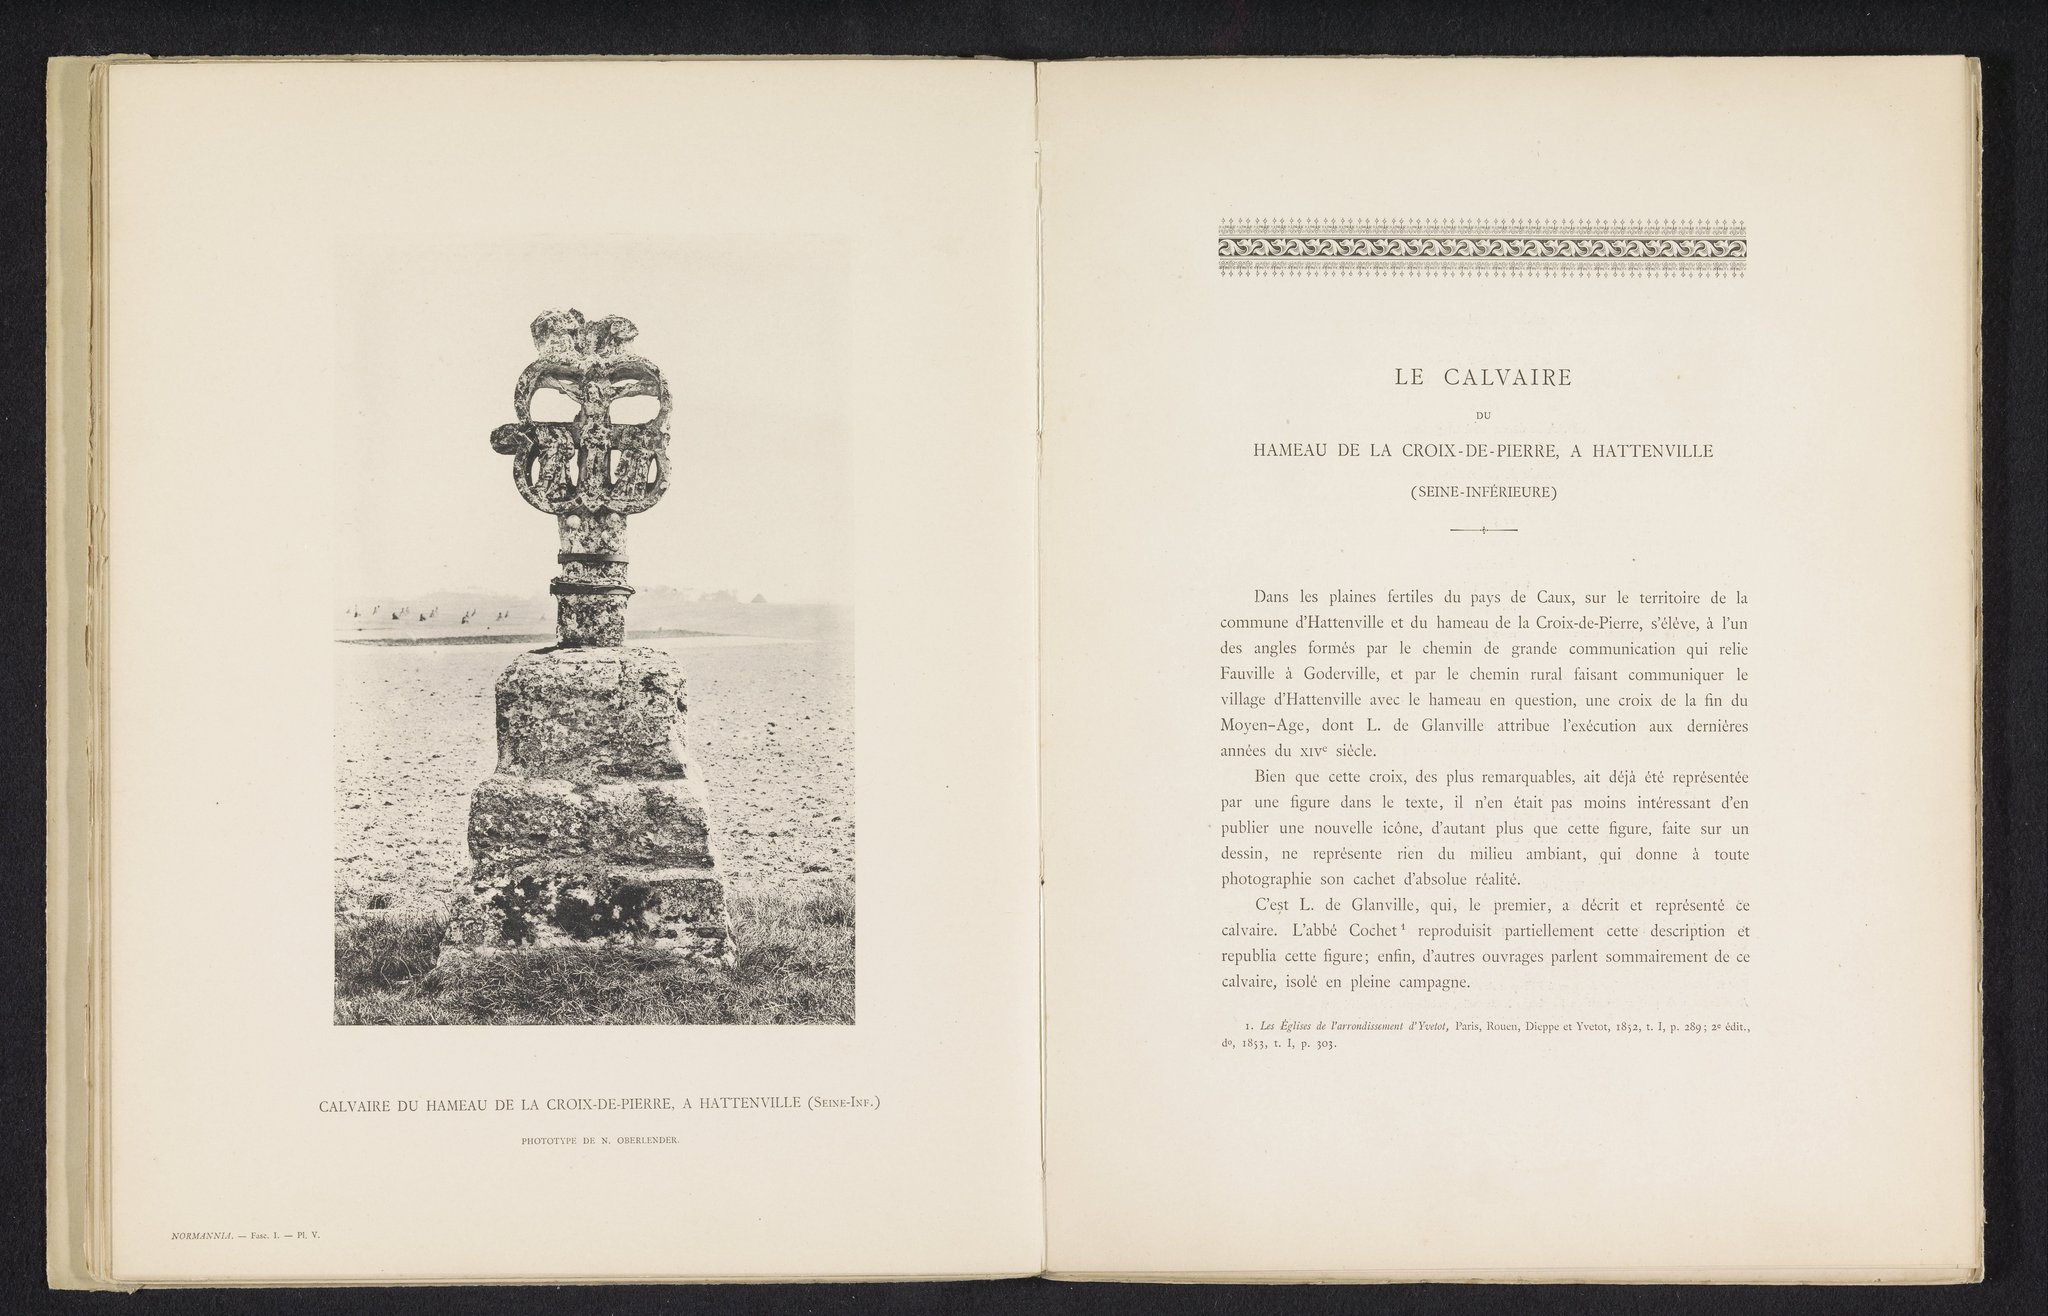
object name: photomechanical print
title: Calvaire du Hameau de la Croix-de-Pierre, A. Hattenville (Seine-Inf.)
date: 1885-1895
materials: paper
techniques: photograph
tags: crucified christ with other persons, sculpture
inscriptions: number: ‘Pl. V.’